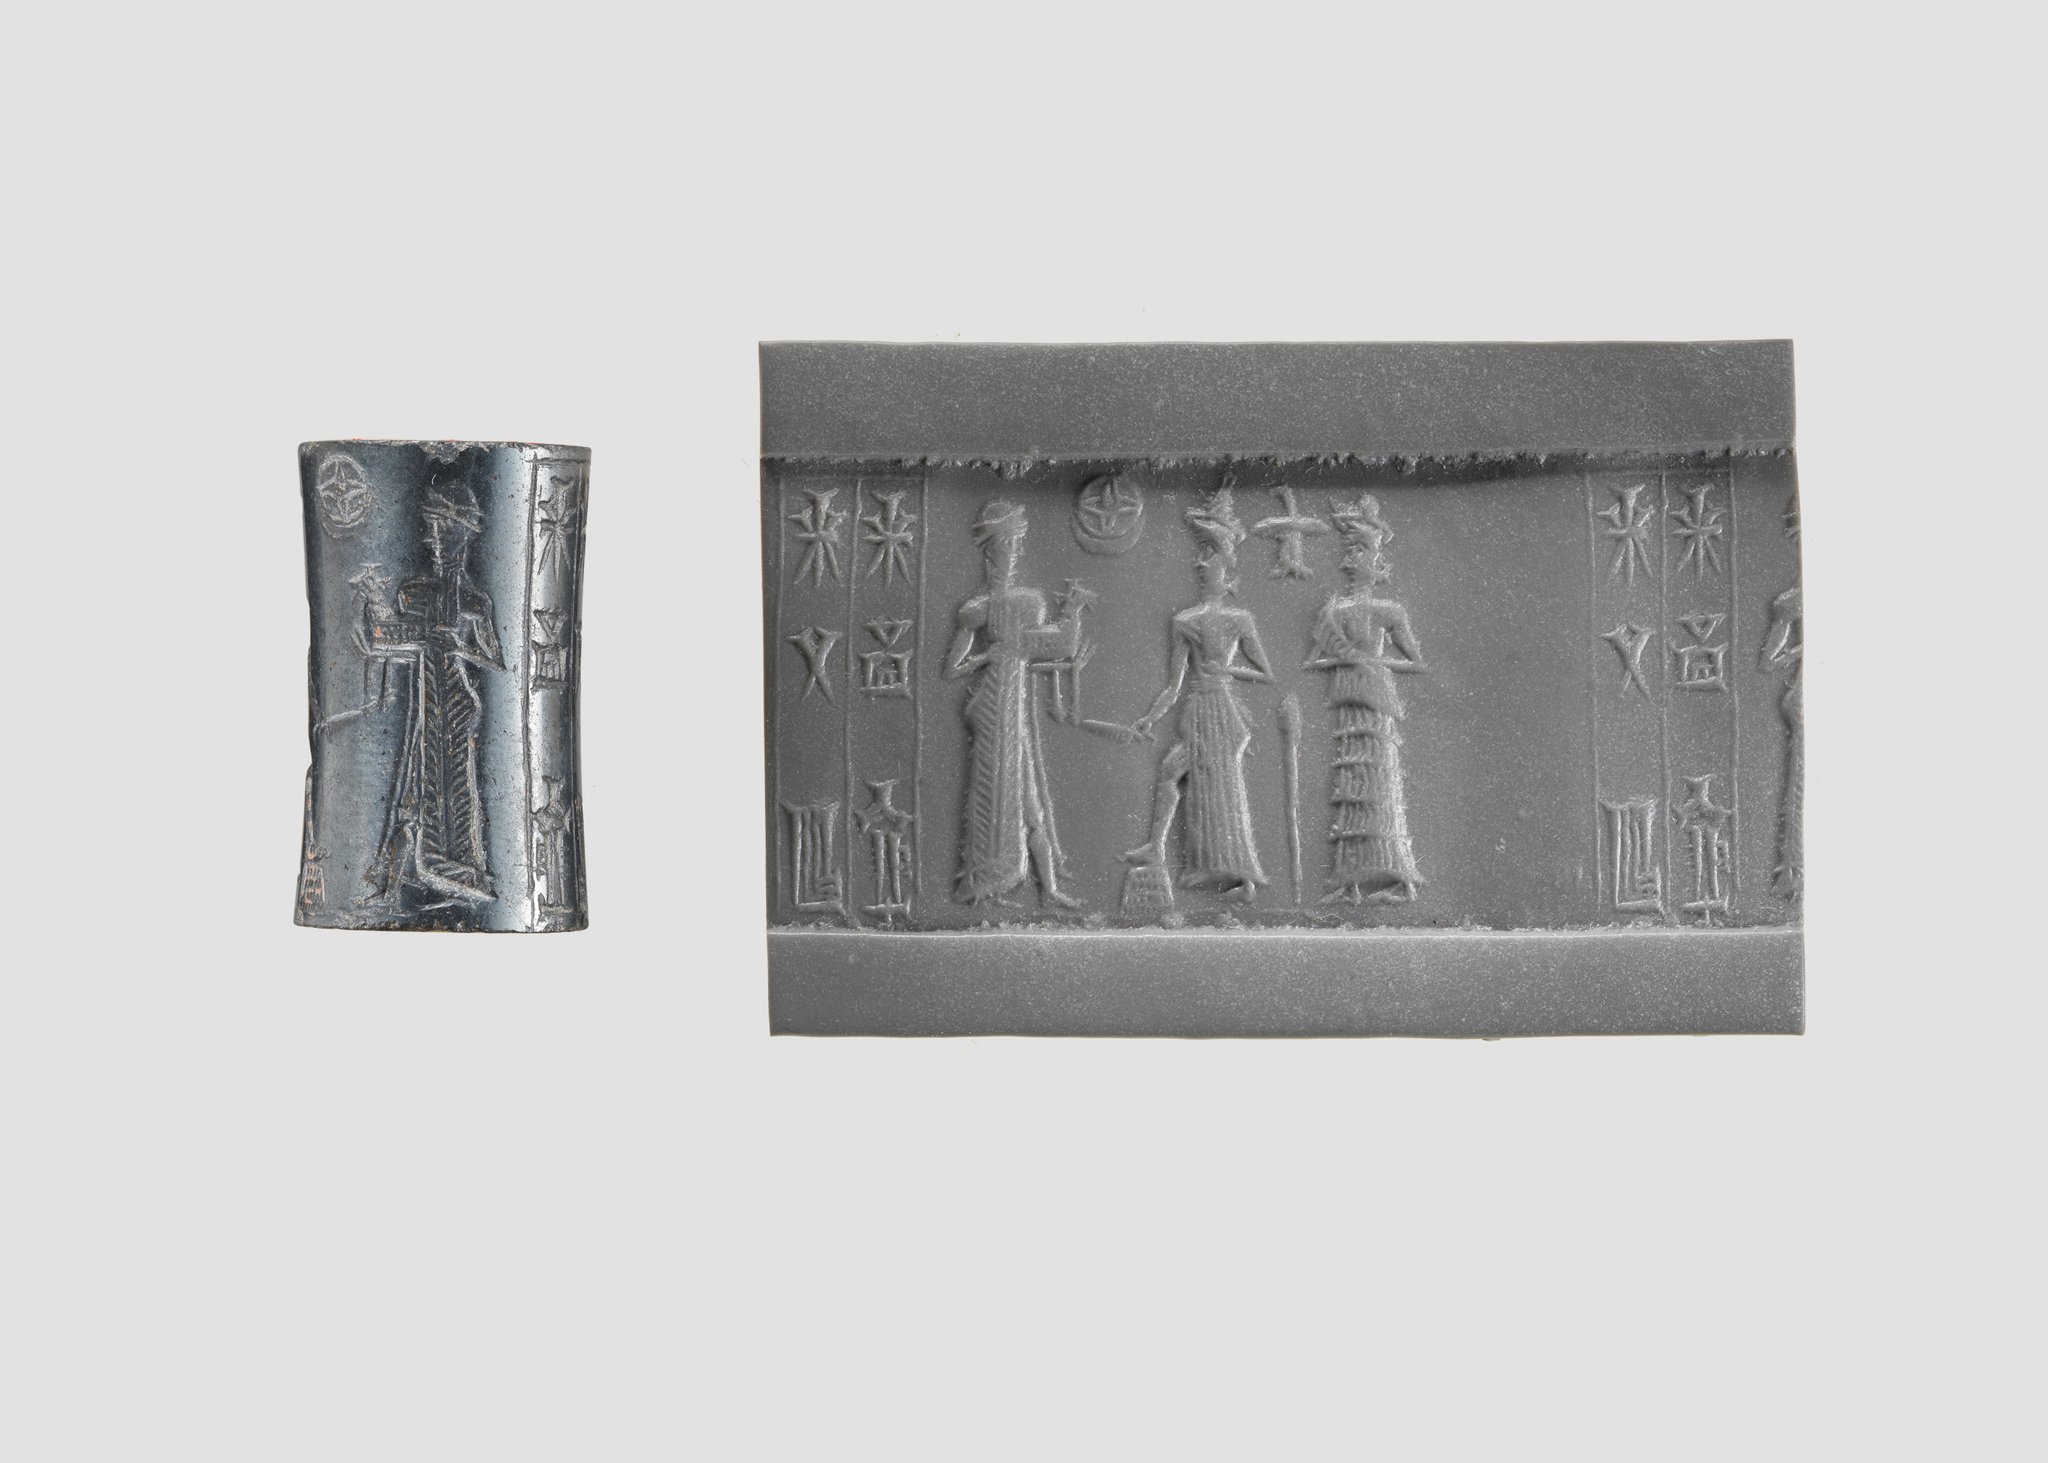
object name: cylinder seal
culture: babylonian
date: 2000-1668 BCE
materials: mineral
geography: mesopotamia